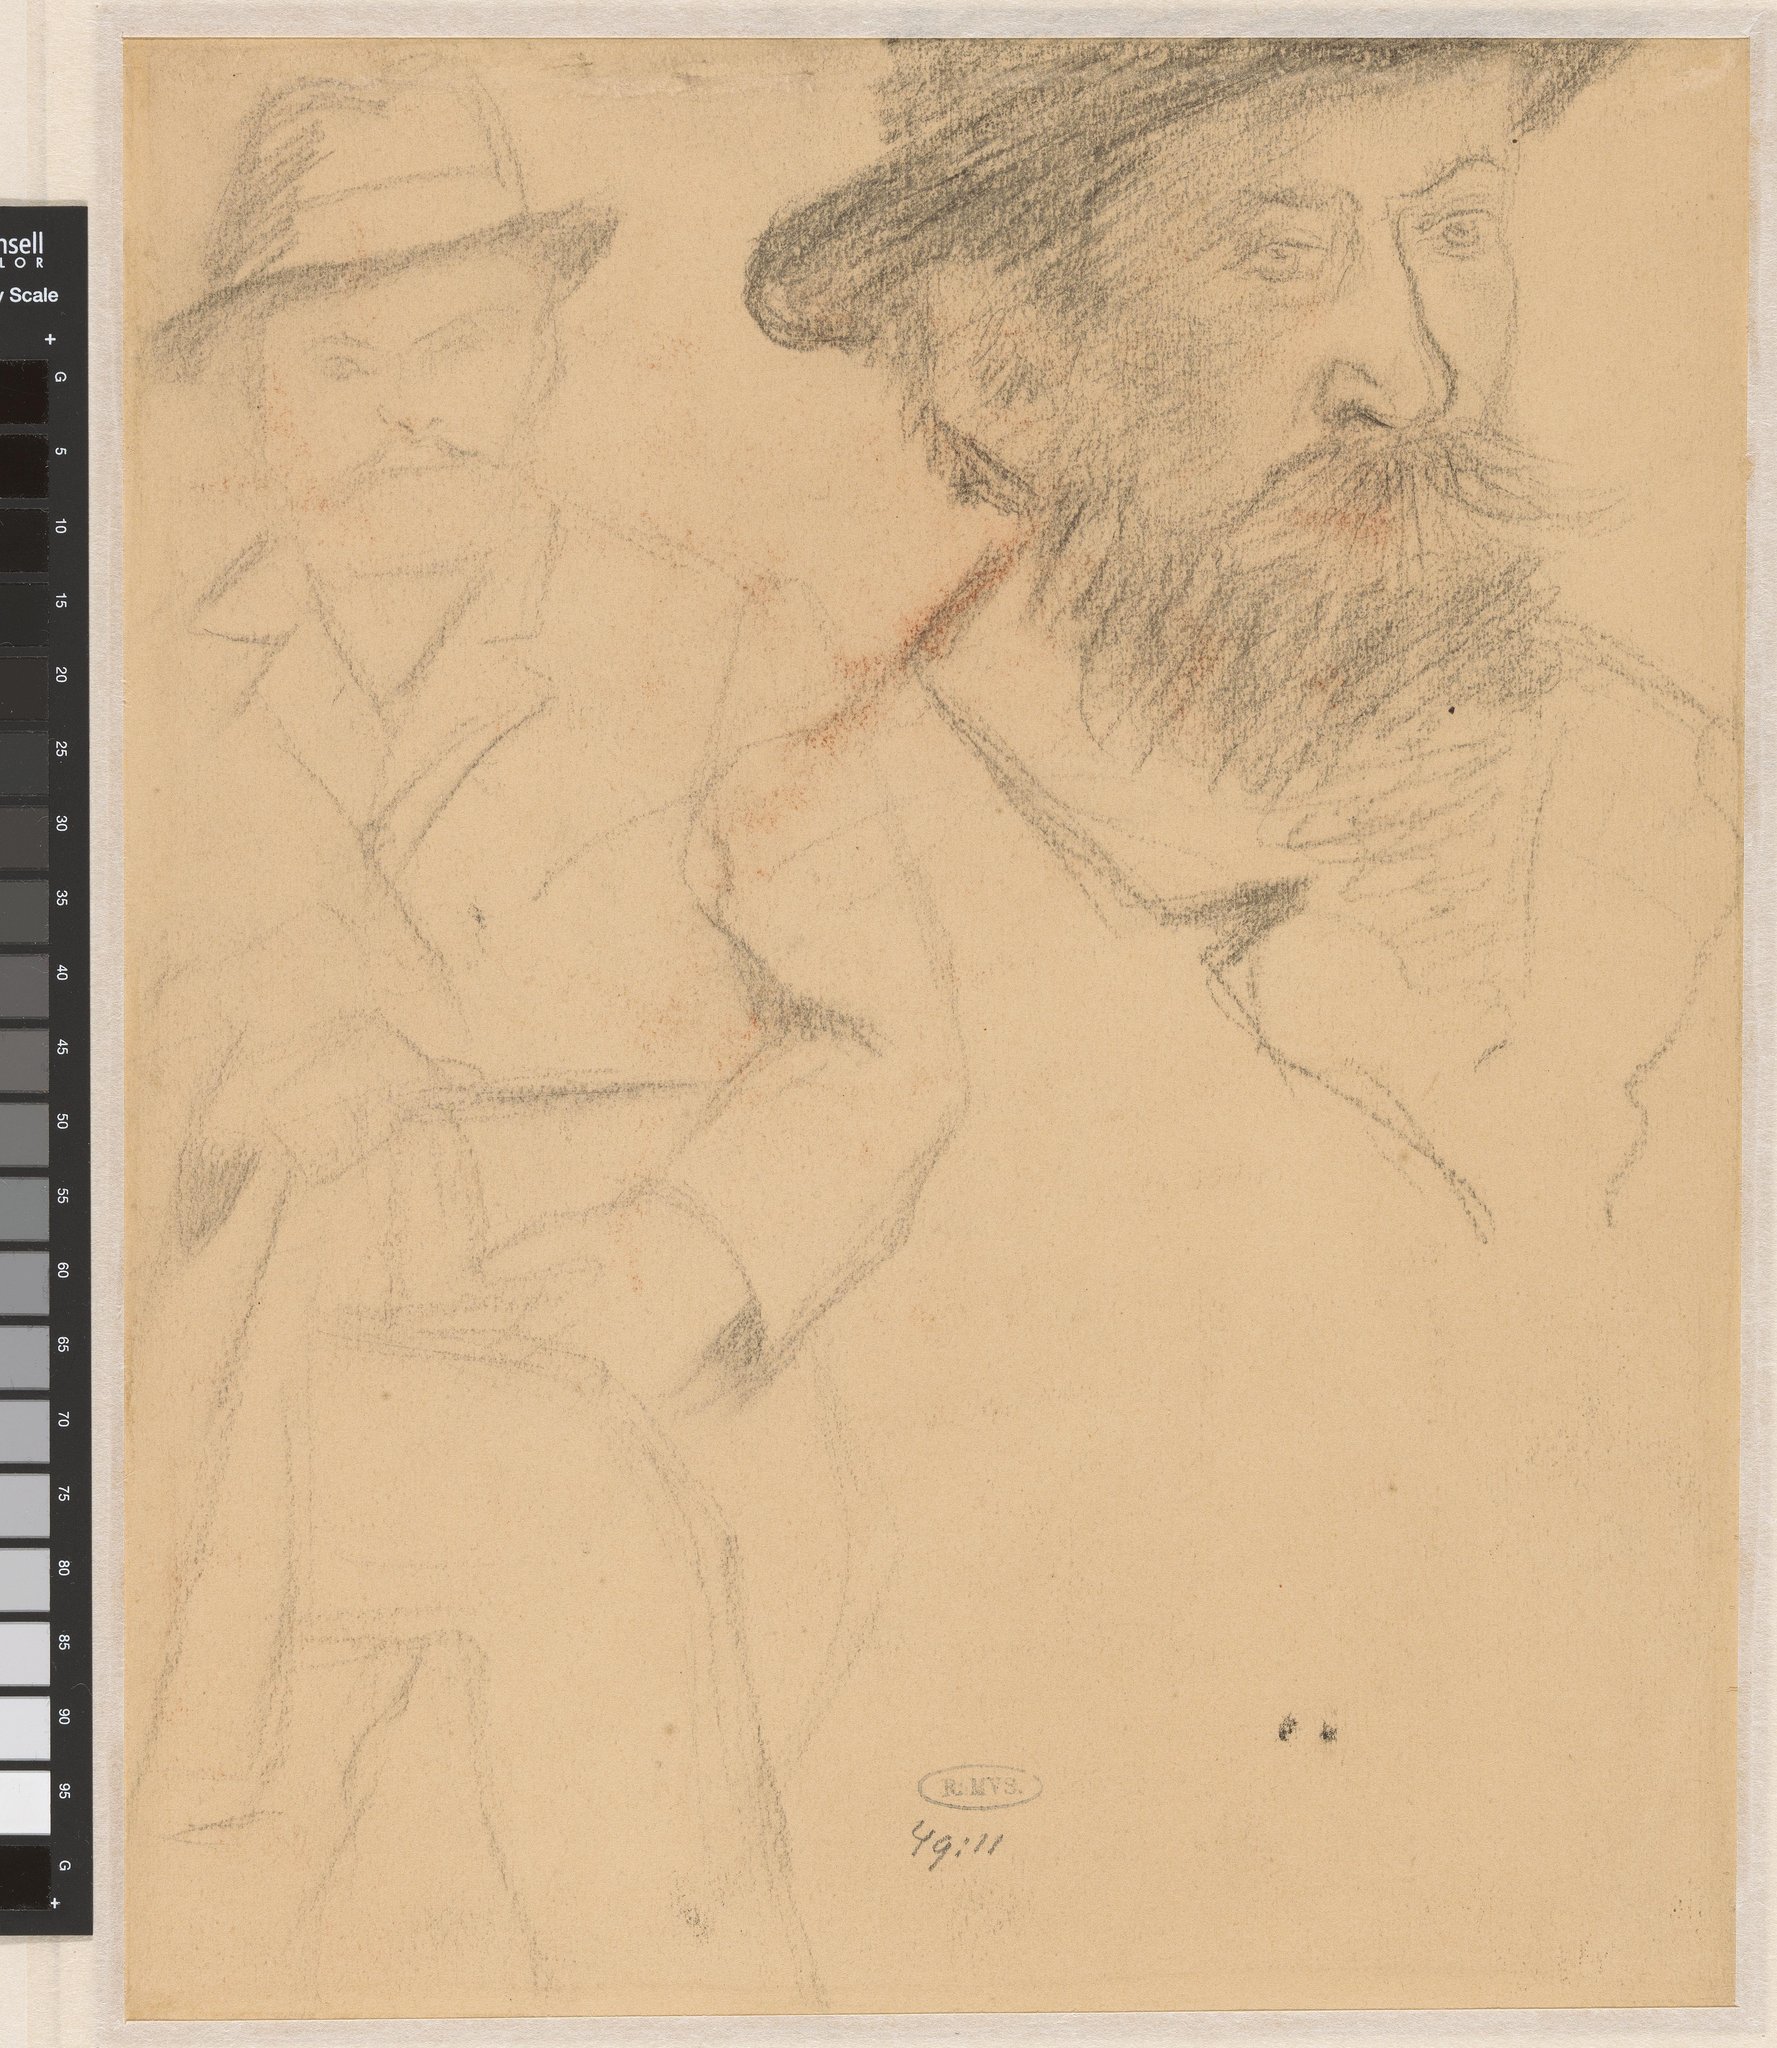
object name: drawing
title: Twee schetsen van een man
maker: Anonymous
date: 1800-1900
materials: chalk, paper